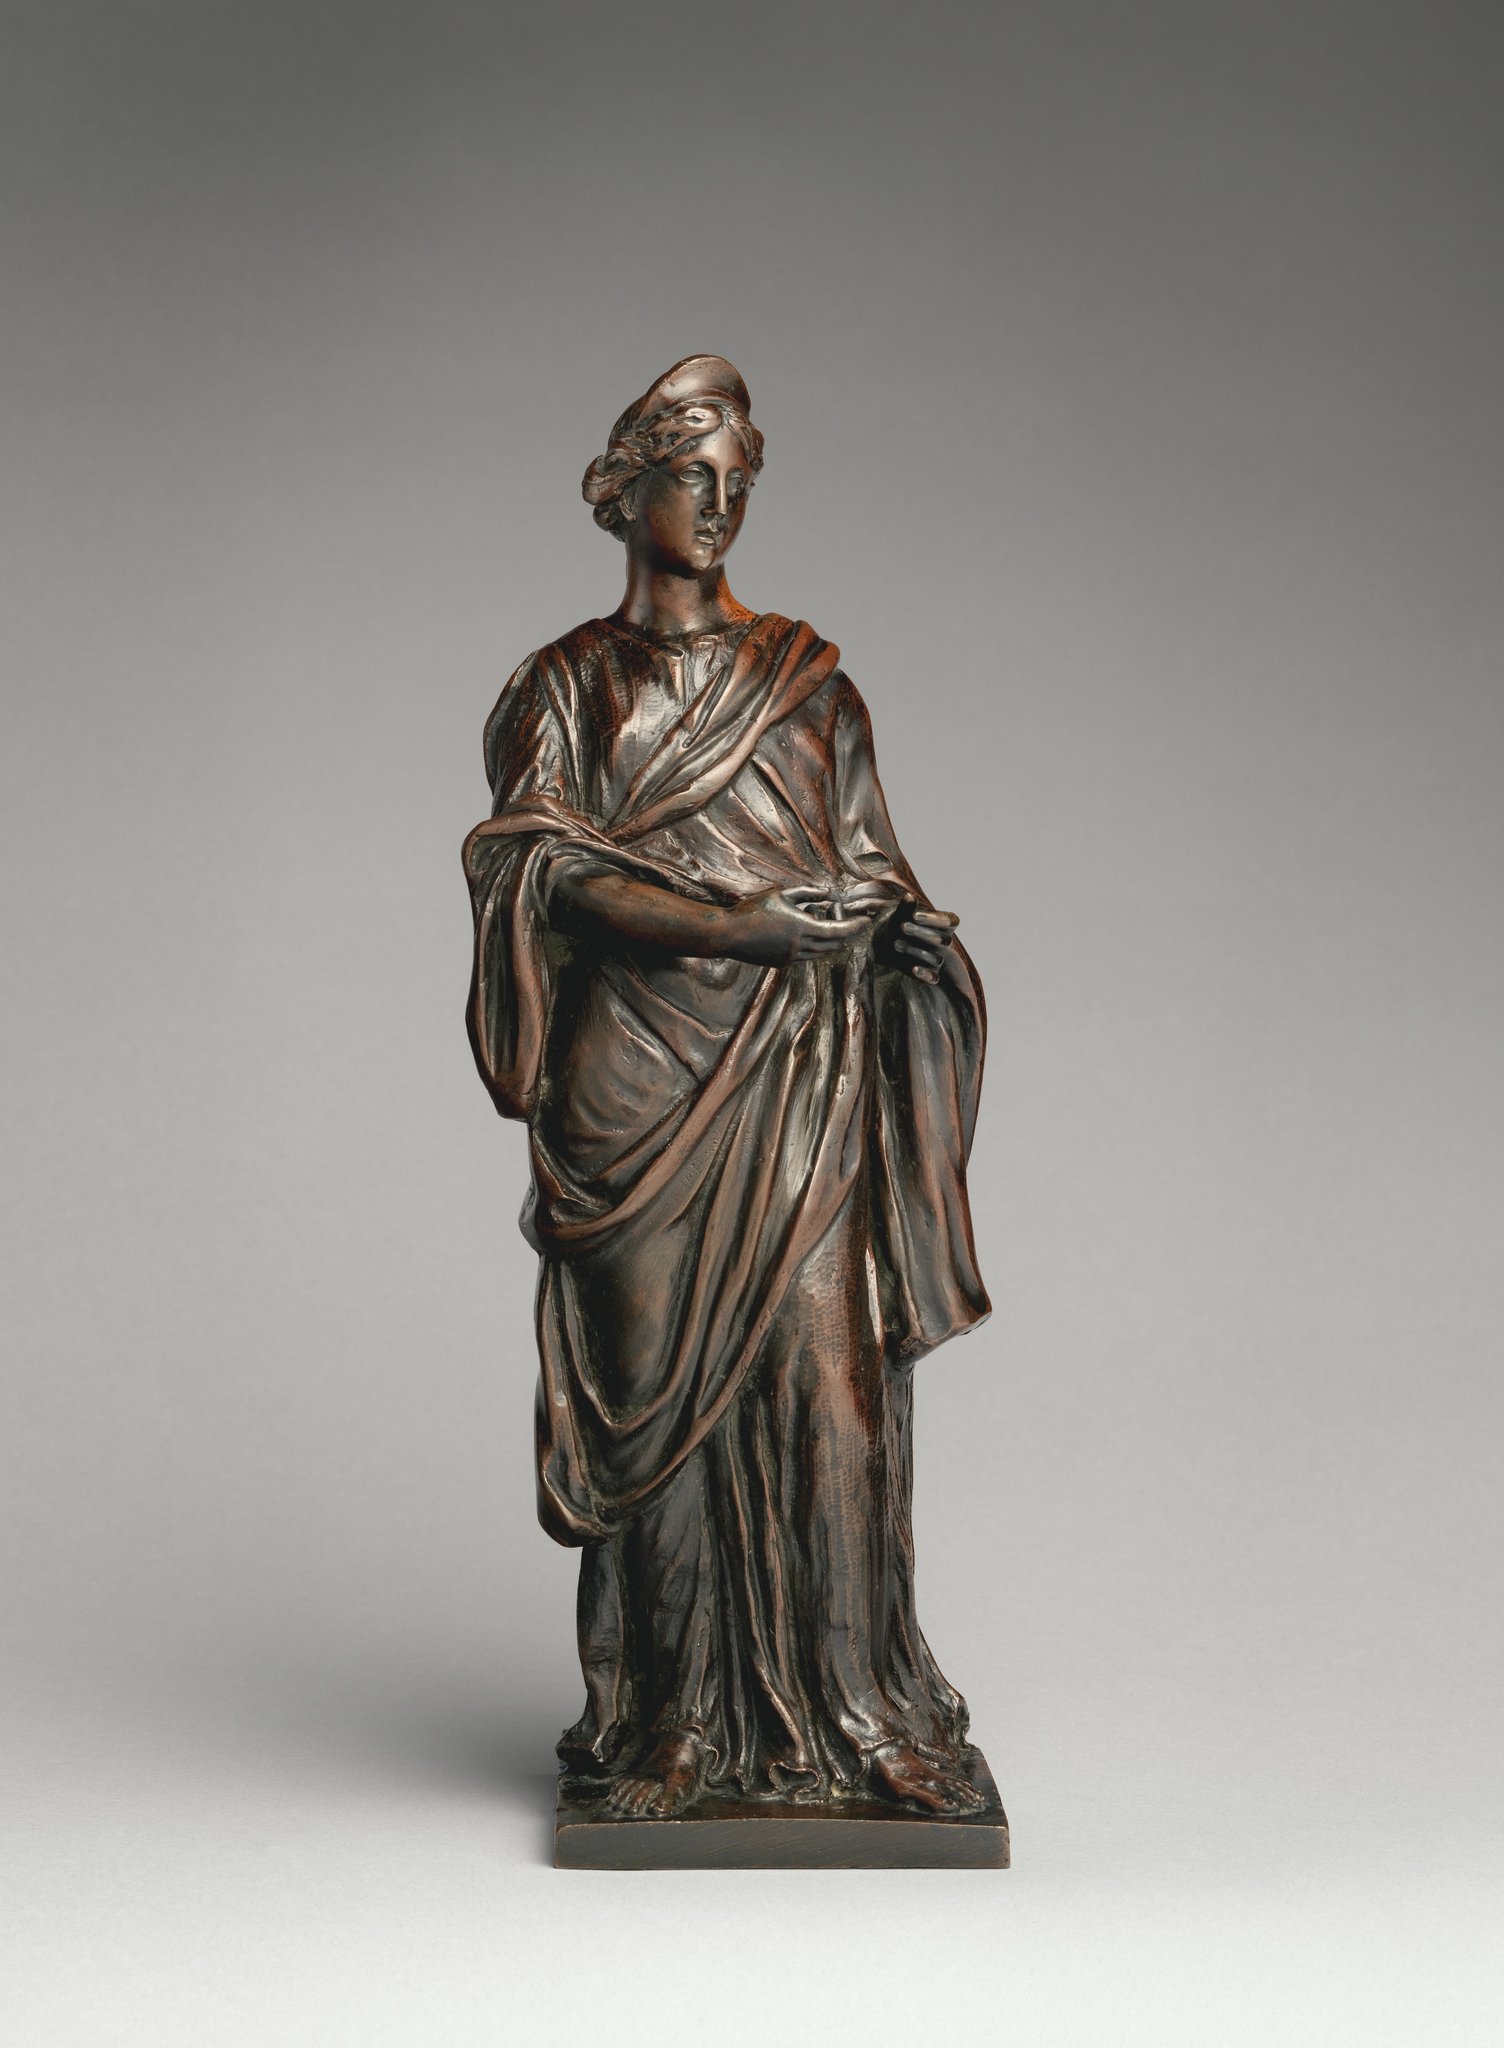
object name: statuette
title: Goddess, after the antique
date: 1601-1800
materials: bronze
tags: goddess